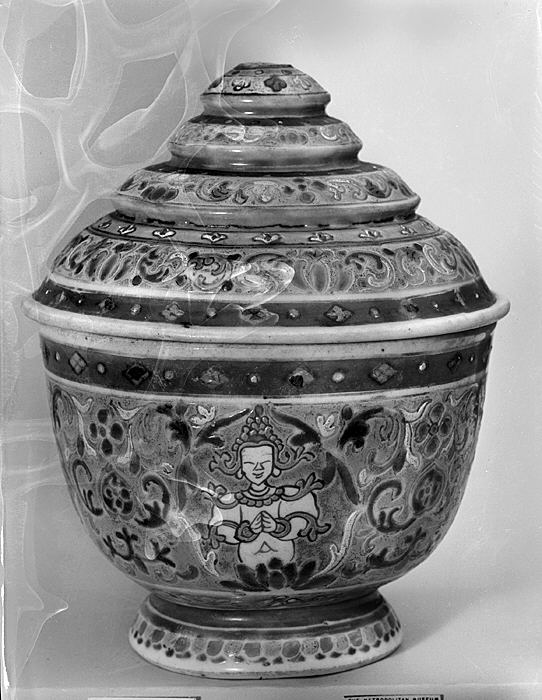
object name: covered urn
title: Covered bowl with Thai celestial beings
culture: chinese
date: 1801-1900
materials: enamel, porcelain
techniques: overglaze, painting, polychrome